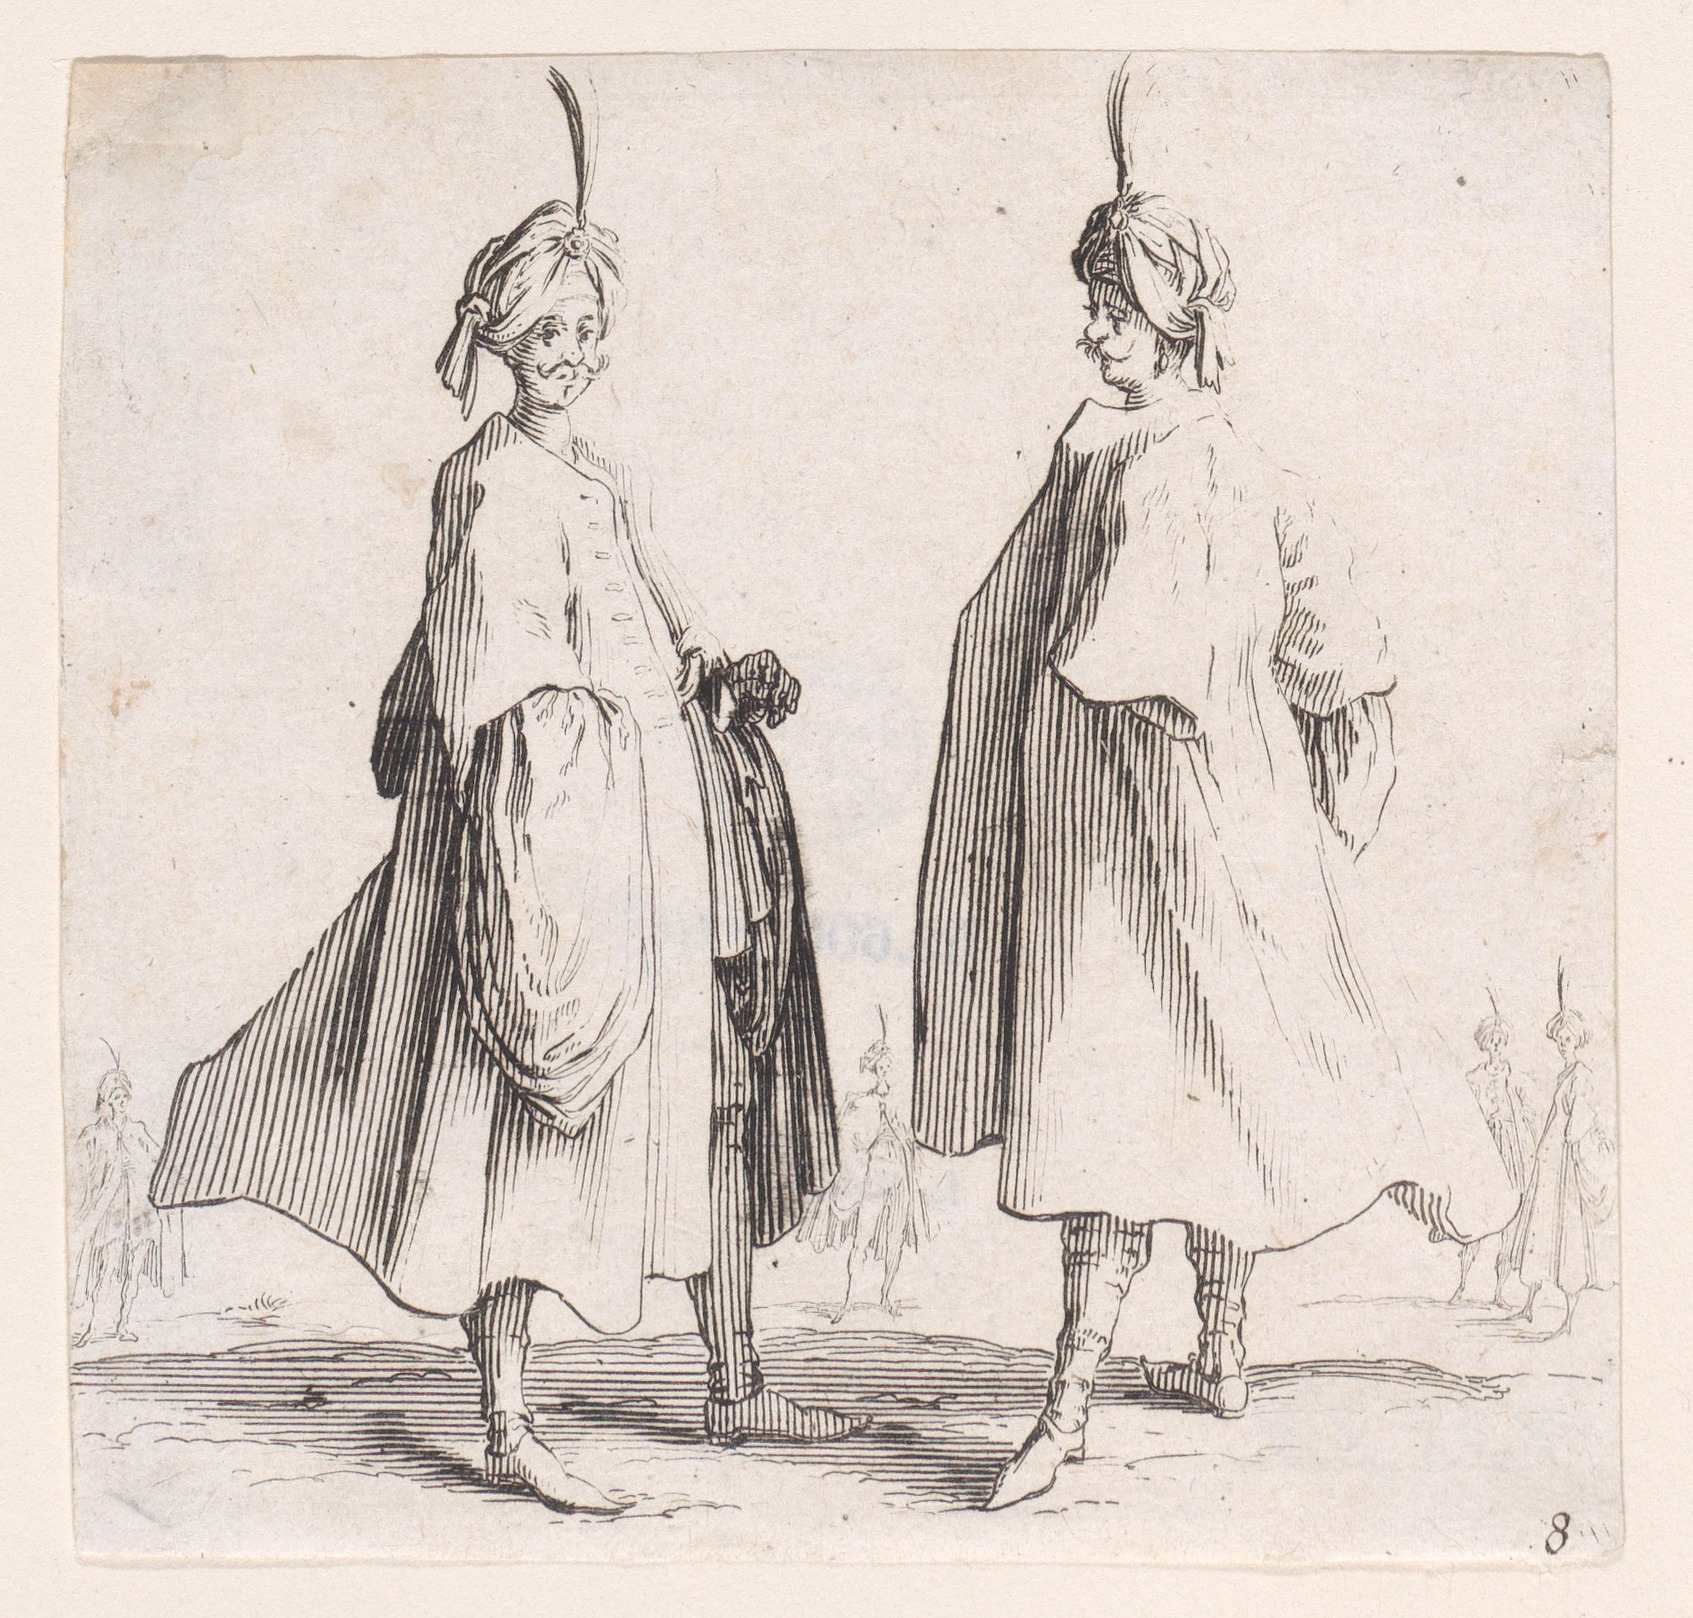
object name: print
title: Les Deux Turcs Coiffés d'un Turban Avec un Aigrette (Two Turks Wearing Turbans with an Egret Feather), plate 8 from "Varie Figure" (Various Figures)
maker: jacques callot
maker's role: artist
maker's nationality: french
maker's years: 1592-1635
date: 1620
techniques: etching